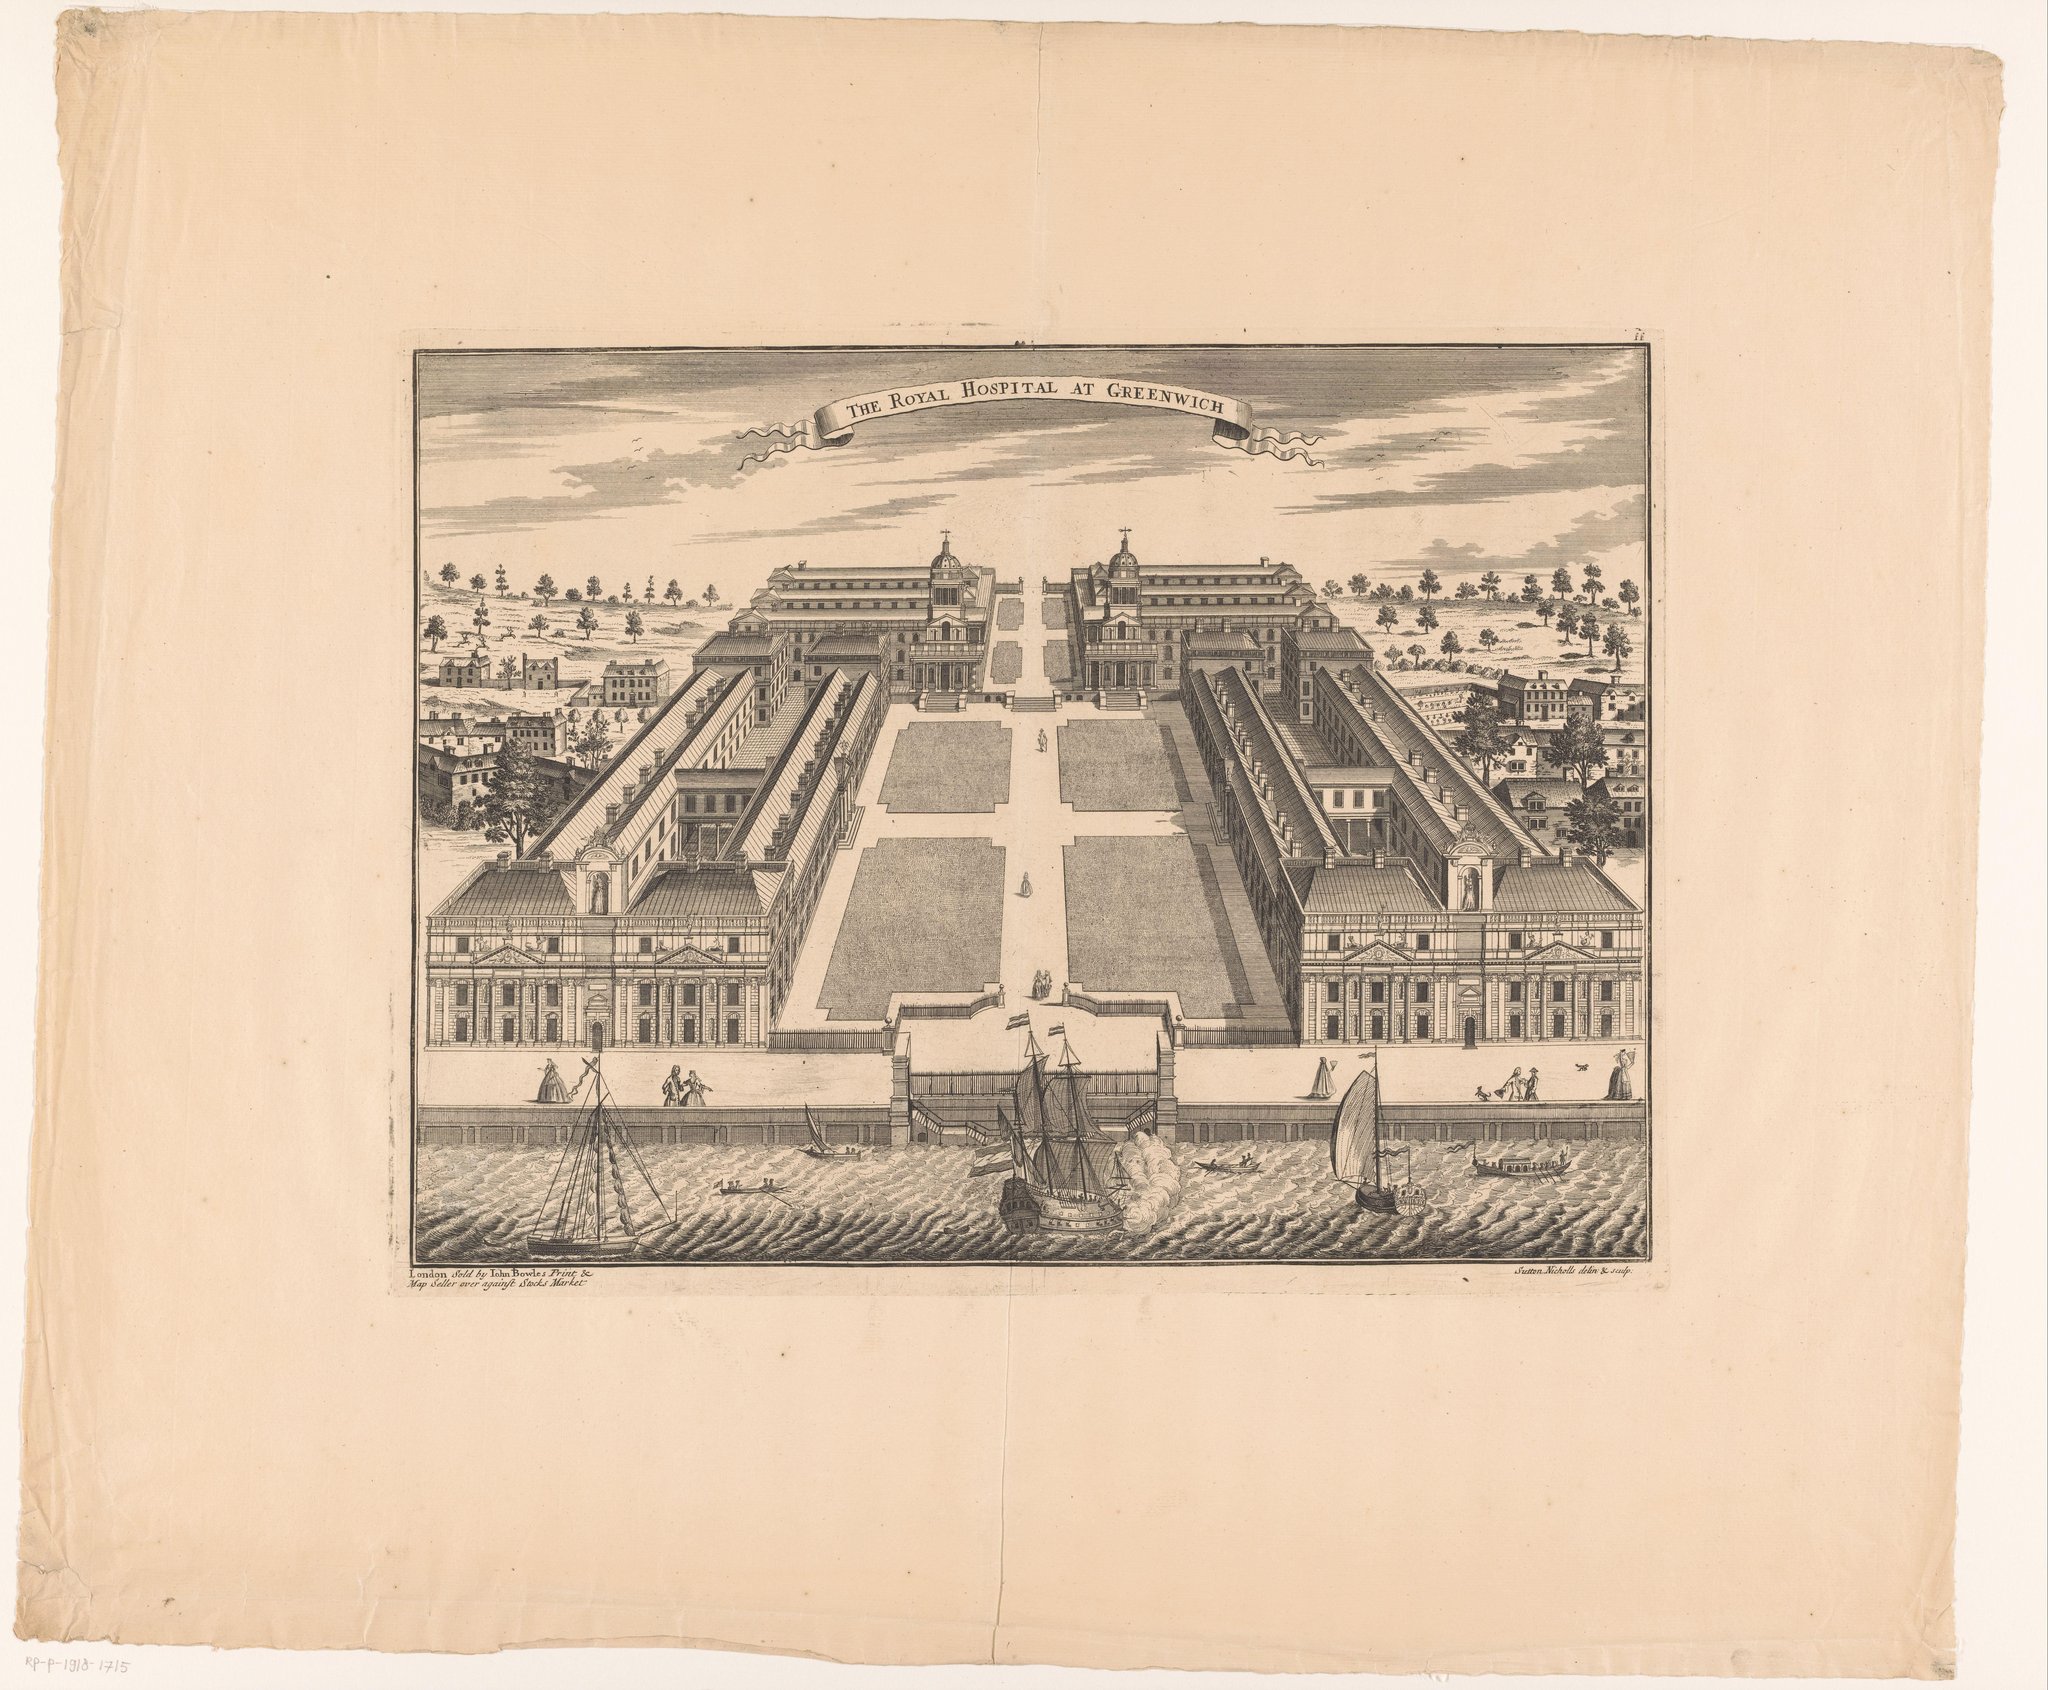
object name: print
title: Gezichten op gebouwen in Londen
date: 1720-1731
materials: paper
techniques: engraving, etching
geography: london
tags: hospital, city-view in general; 'veduta' (+ city(-scape) with figures, staffage), london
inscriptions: collector's mark: Lugt 2233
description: Deze reeks werd voor het eerst compleet uitgegeven in 1731, al zijn de losse prenten al voor die tijd uitgebracht. De meeste prenten zijn vervaardigd door Sutton Nicholls. De serie werd aangeboden voor verkoop door John Bowles in zijn catalogus 1753, op pagina 76, nummer 16.